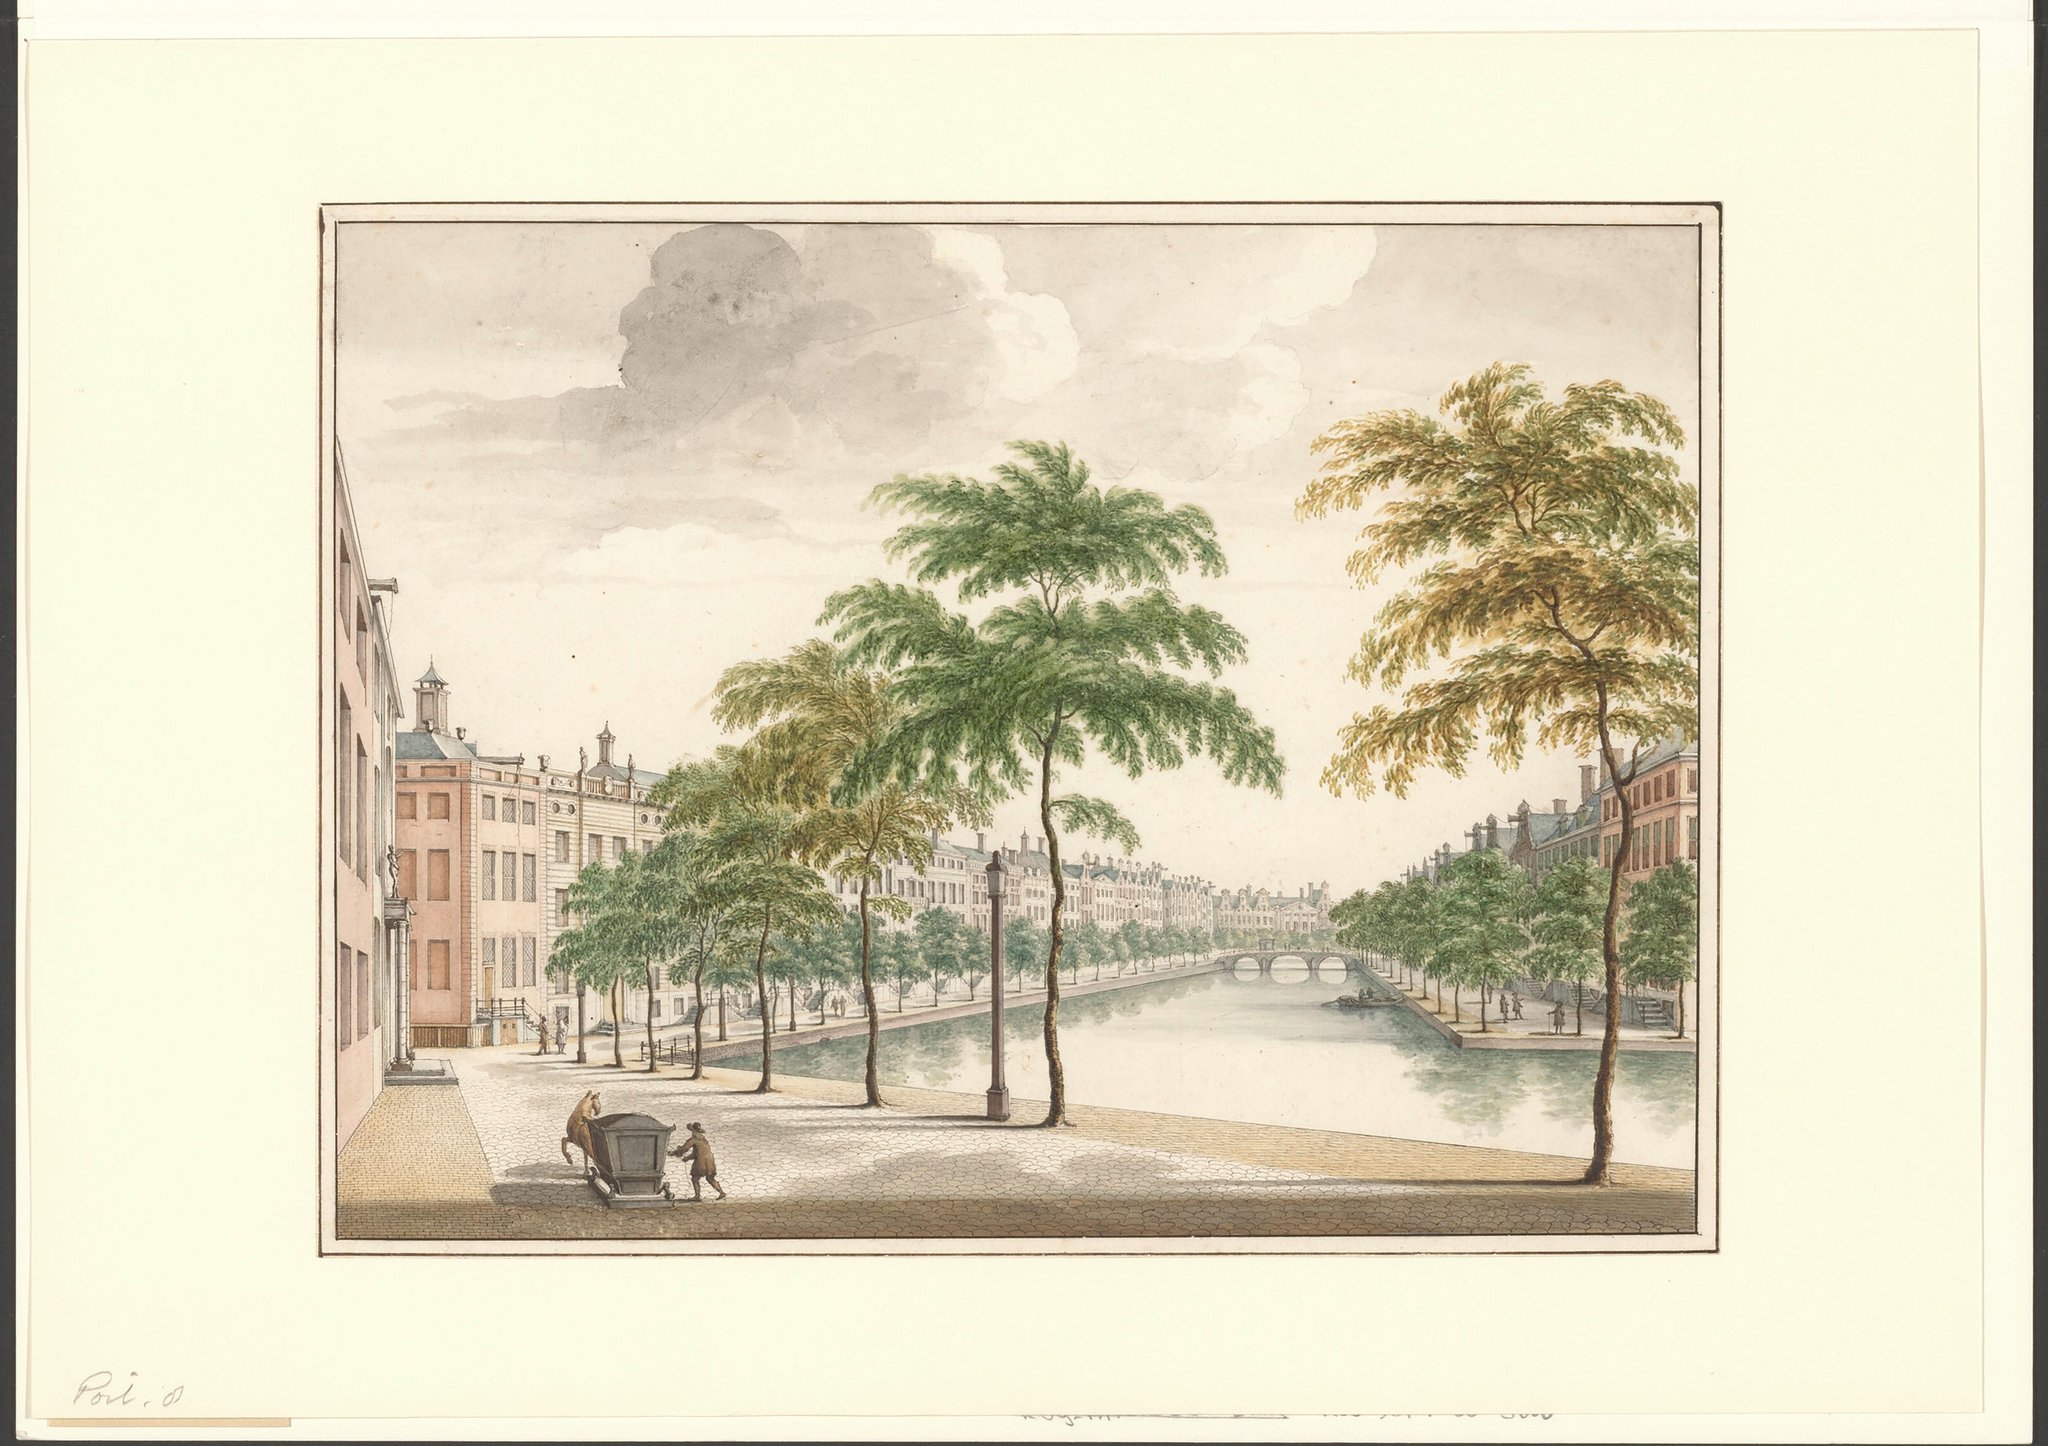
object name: drawing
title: Gezicht op de Herengracht, gezien vanaf de Vijzelstraat naar de Leidsestraat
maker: jan van call (i)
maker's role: draughtsman, print maker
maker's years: 1656-1706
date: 1666-1703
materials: ink, paper, pencil, watercolor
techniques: brush, pen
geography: amsterdam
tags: city-view in general; 'veduta', canal, bridge in city across river, canal, etc., street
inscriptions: inscription: ‘Heeregragt van de Vijzelstraat na 't Koningsplein’, collector's mark: ‘8’ Lugt 1641b, inscription: ‘Port. 8’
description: Onderwerpsrubriek binnen de Atlas Amsterdam: Haarlemmerplein, Halvemaansteeg, Handboogstraat, Handelskade, Haringpakkerij, Hartenstraat, Hasseltsteeg (Dirk van), Heerengracht.